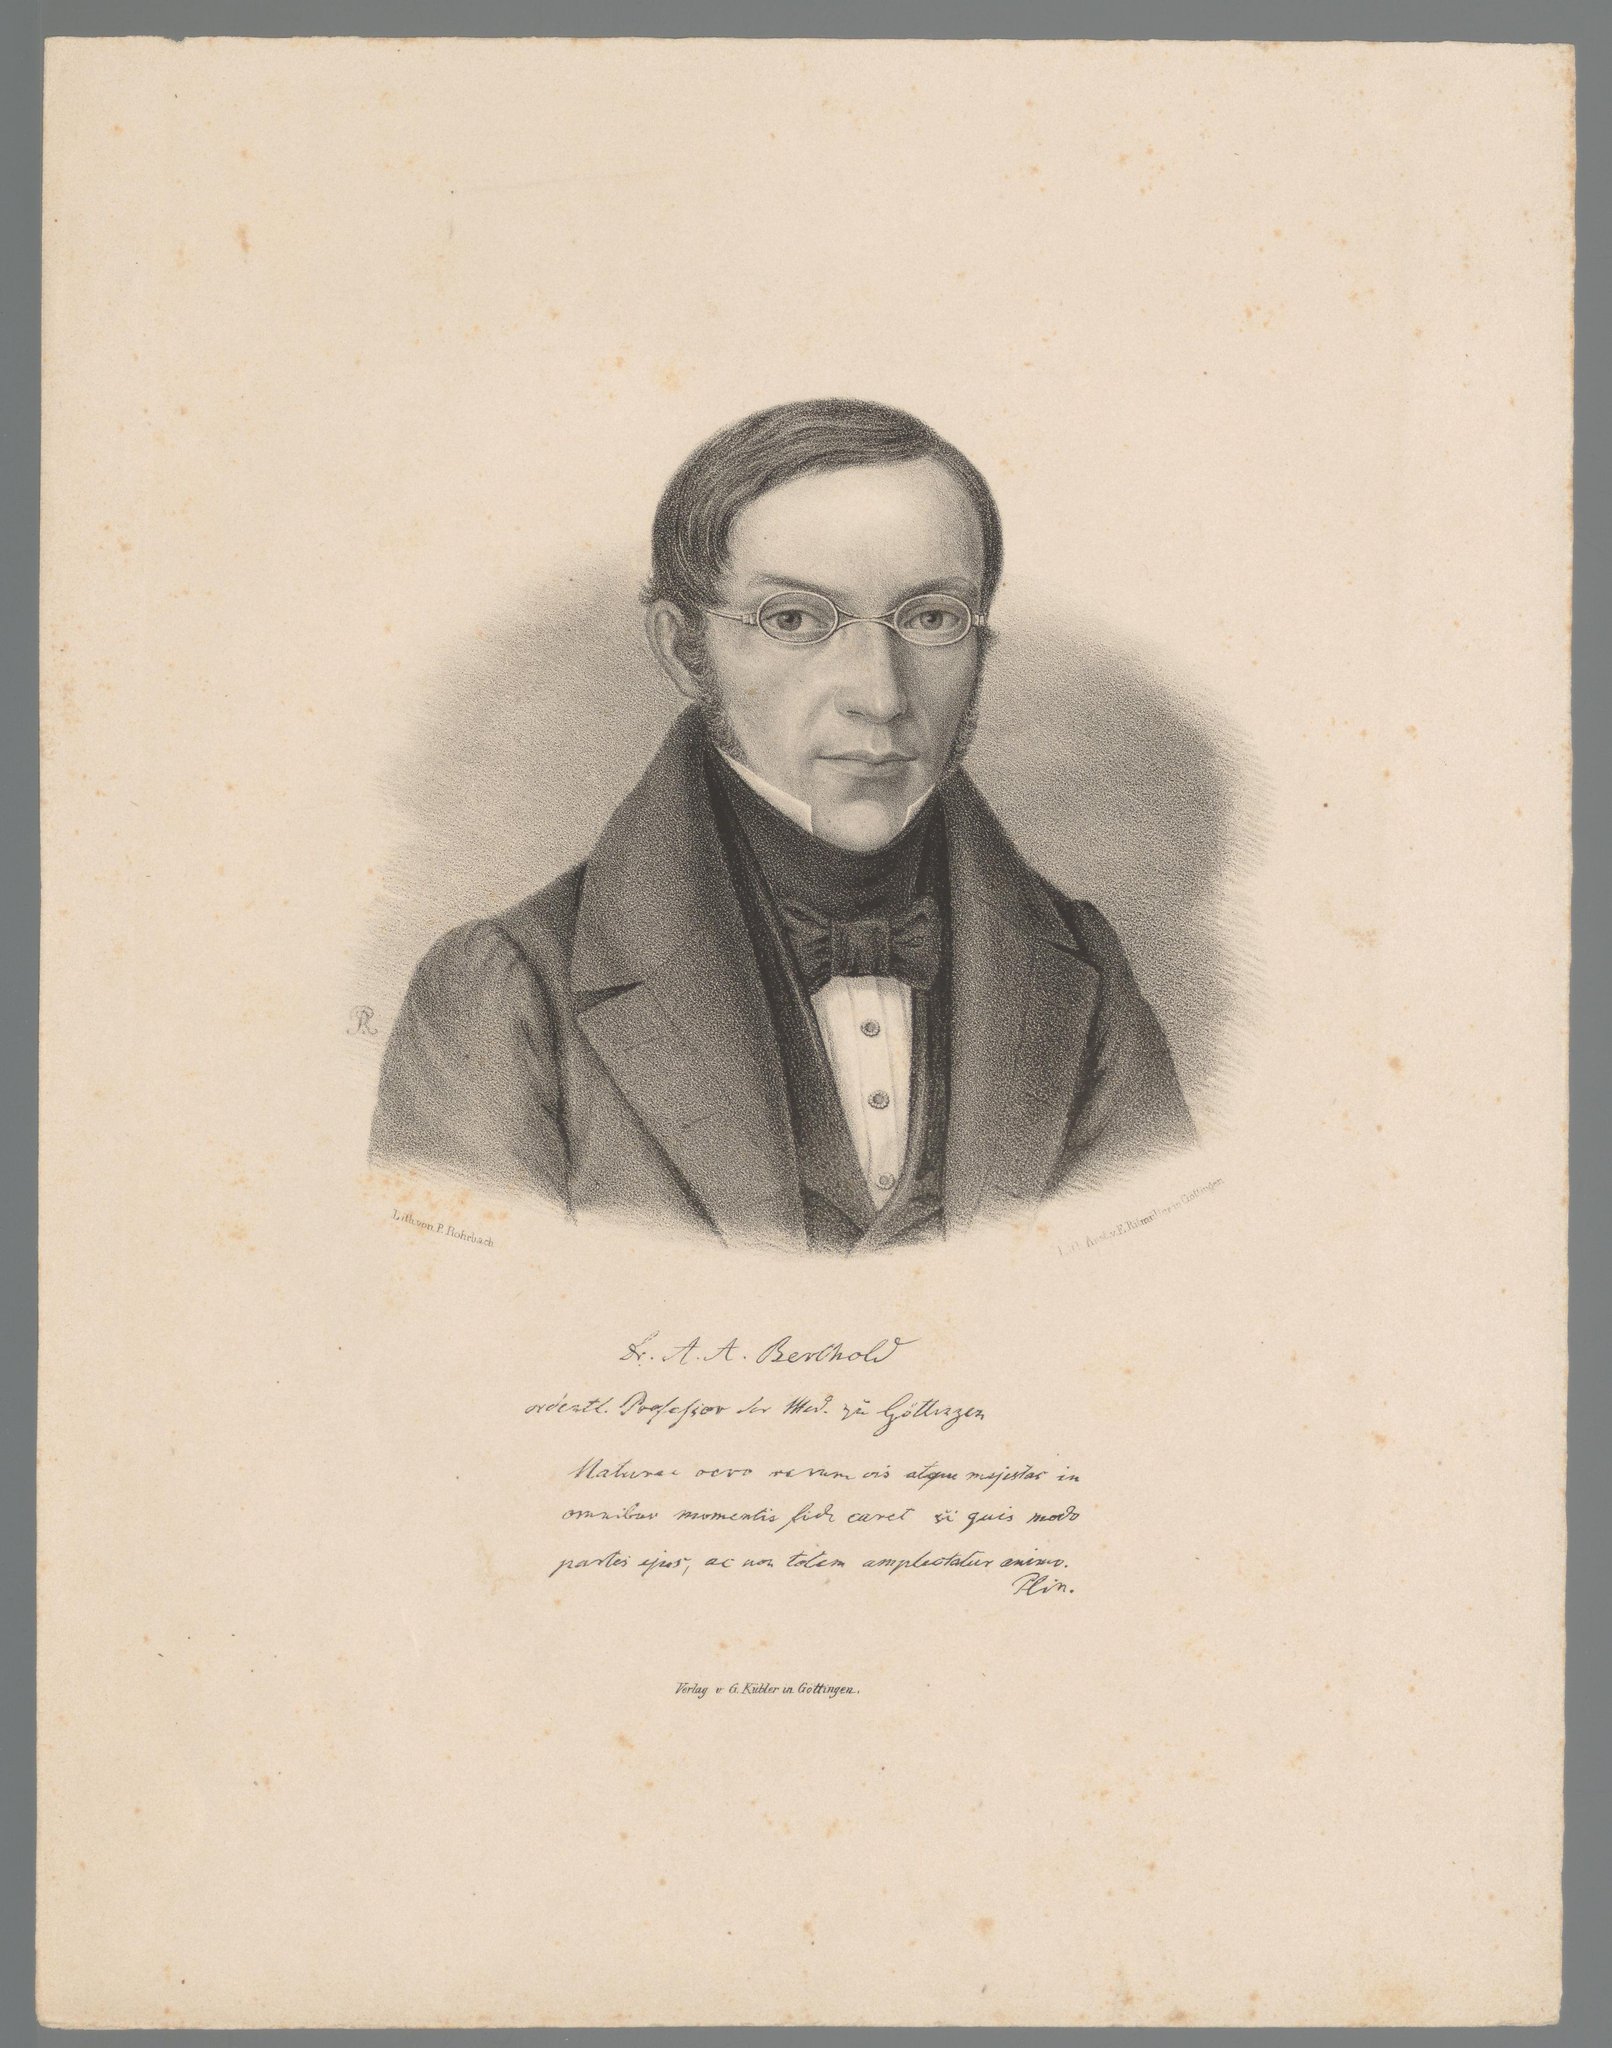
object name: print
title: Portret van Arnold Adolph Berthold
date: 1827-1868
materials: paper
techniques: lithograph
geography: gottingen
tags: historical persons, scholar, philosopher (+ portrait of scholar, scientist)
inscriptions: collector's mark: Lugt 2228